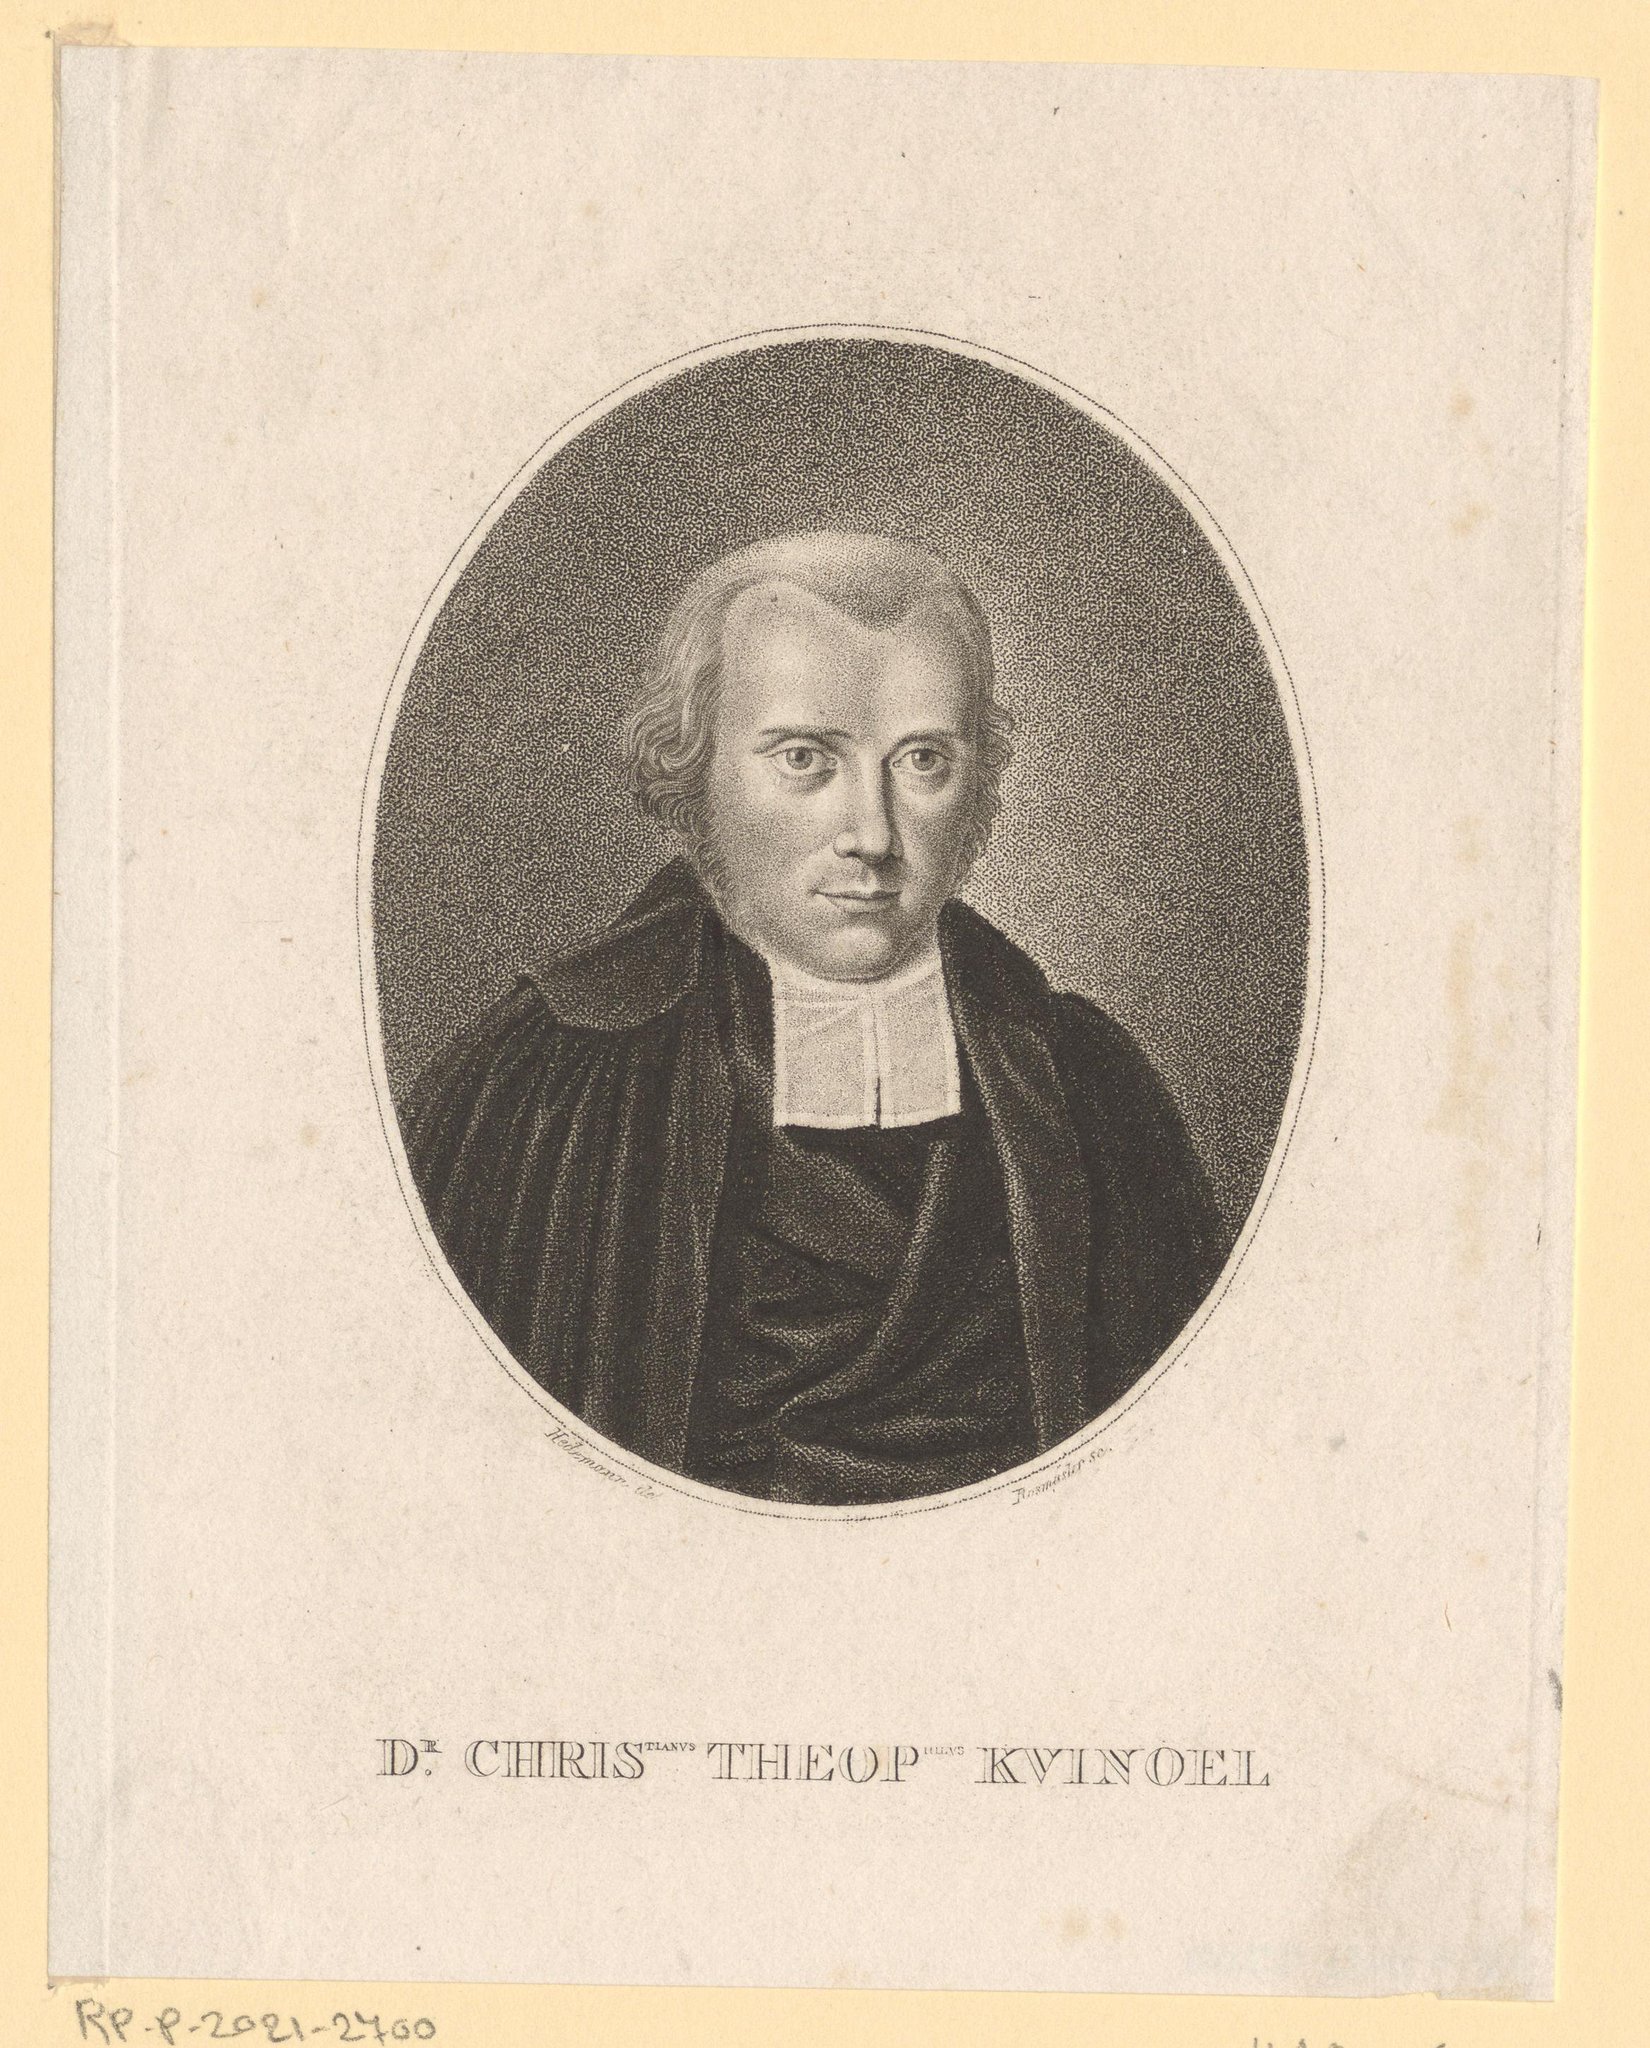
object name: print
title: Portret van Christian Gottlieb Kühnöl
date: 1816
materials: paper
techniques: engraving, etching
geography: leipzig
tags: historical persons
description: Prent mogelijk uit: Kühnöl, Christian Gottlieb. Commentarius in libros novi testamenti. Leipzig: Johann Ambrosius Barth, 1816, dl. 1.